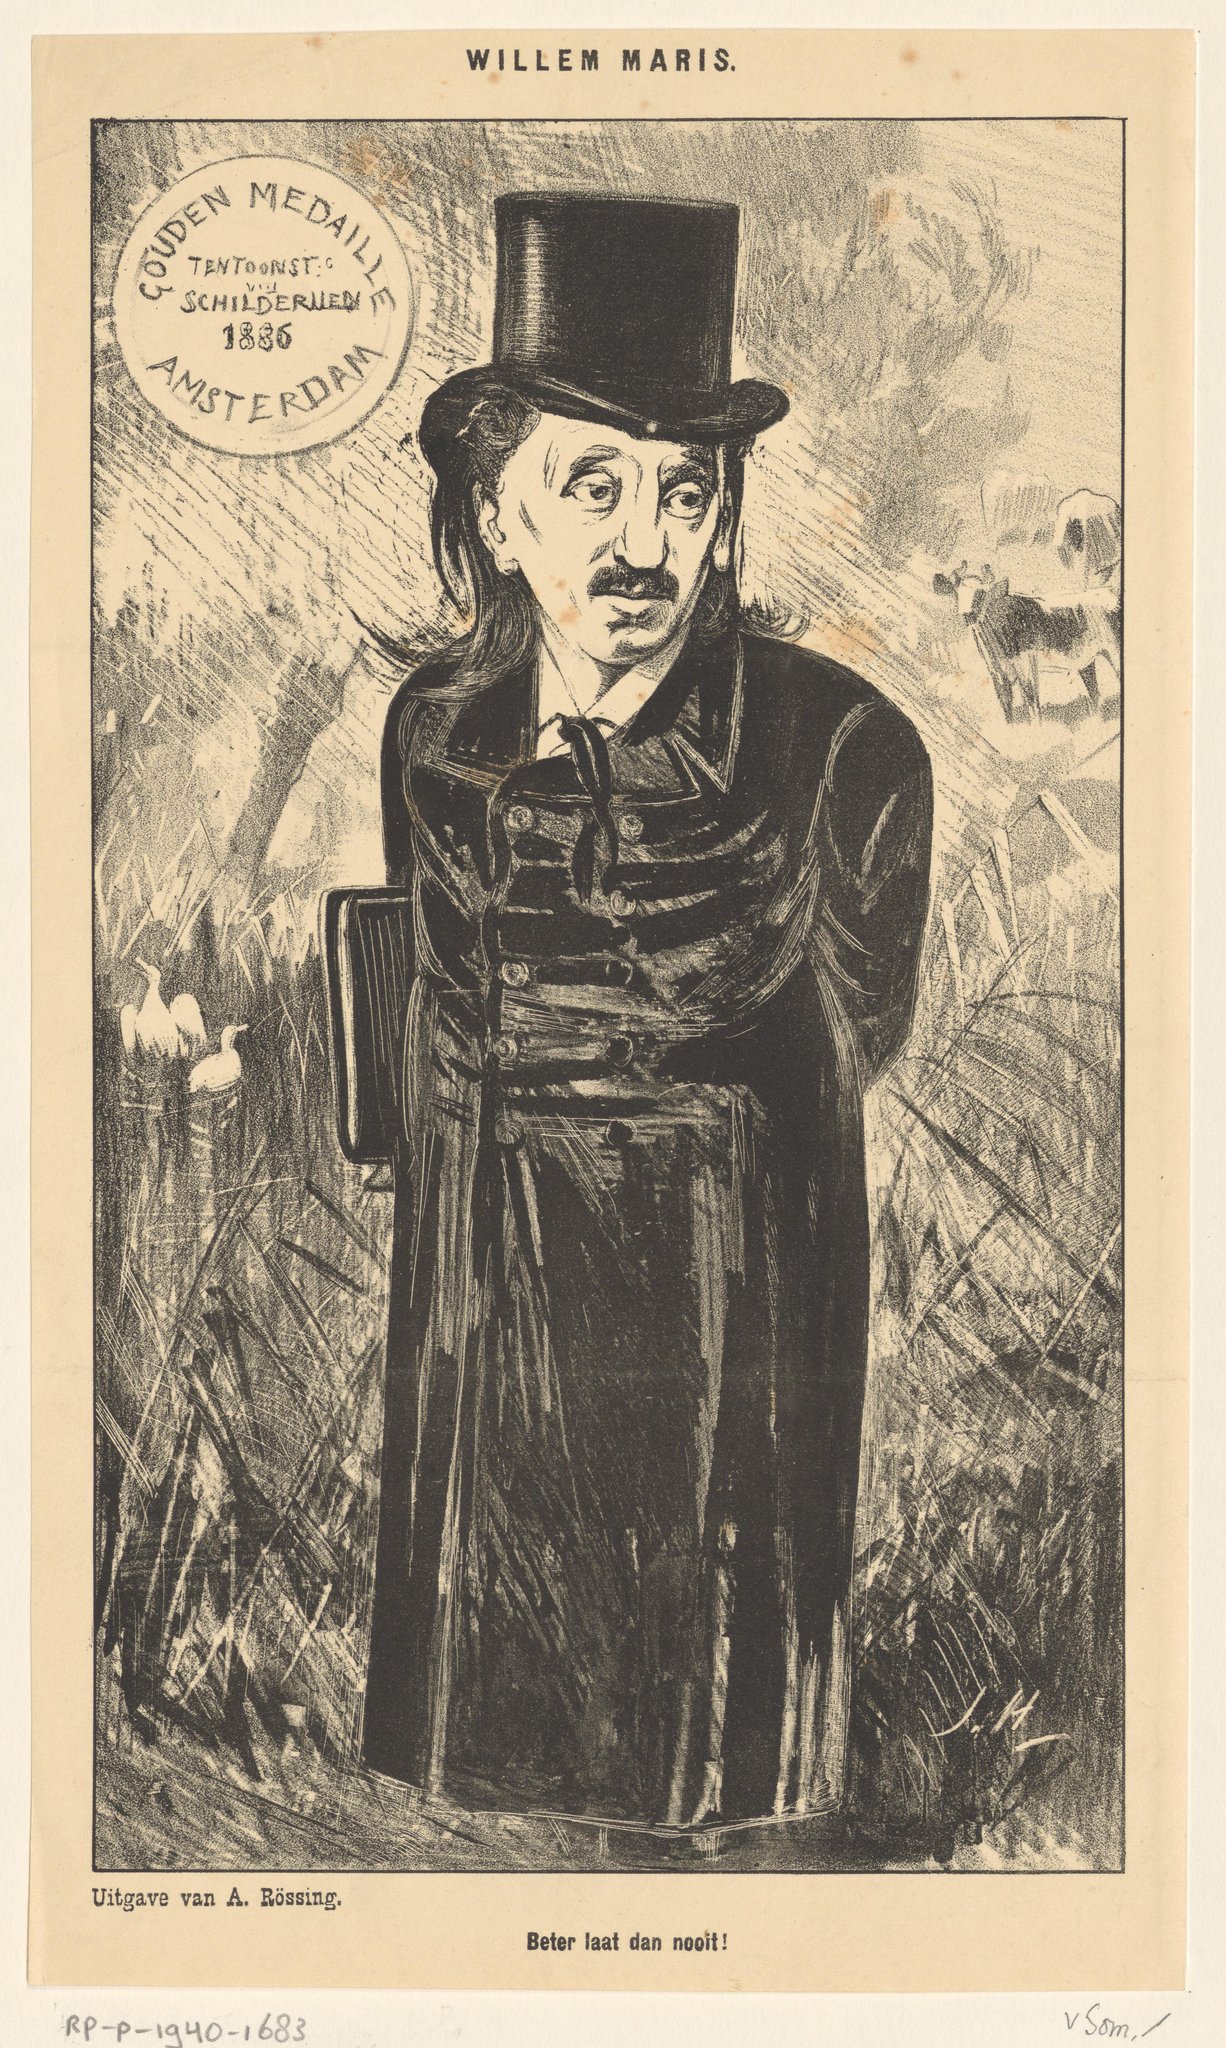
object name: cartoon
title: Spotprent met Willem Maris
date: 1886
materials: paper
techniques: lithograph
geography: the hague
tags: the hague, painter, draughtsman, willem maris, caricatures (human types), historical persons, portrait, self-portrait of painter, parody on art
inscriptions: collector's mark: Lugt 2760, inscription: ‘uit kelder depôt/ 2002’, collector's mark: Lugt 2166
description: Maris staat voor een landschap met eenden en koeien. Linksboven een medaille met daarop: 'Gouden Medaille Tentoonst: van Schilderijen 1886 Amsterdam.' Onder de prent het onderschrift: Beter laat dan nooit!